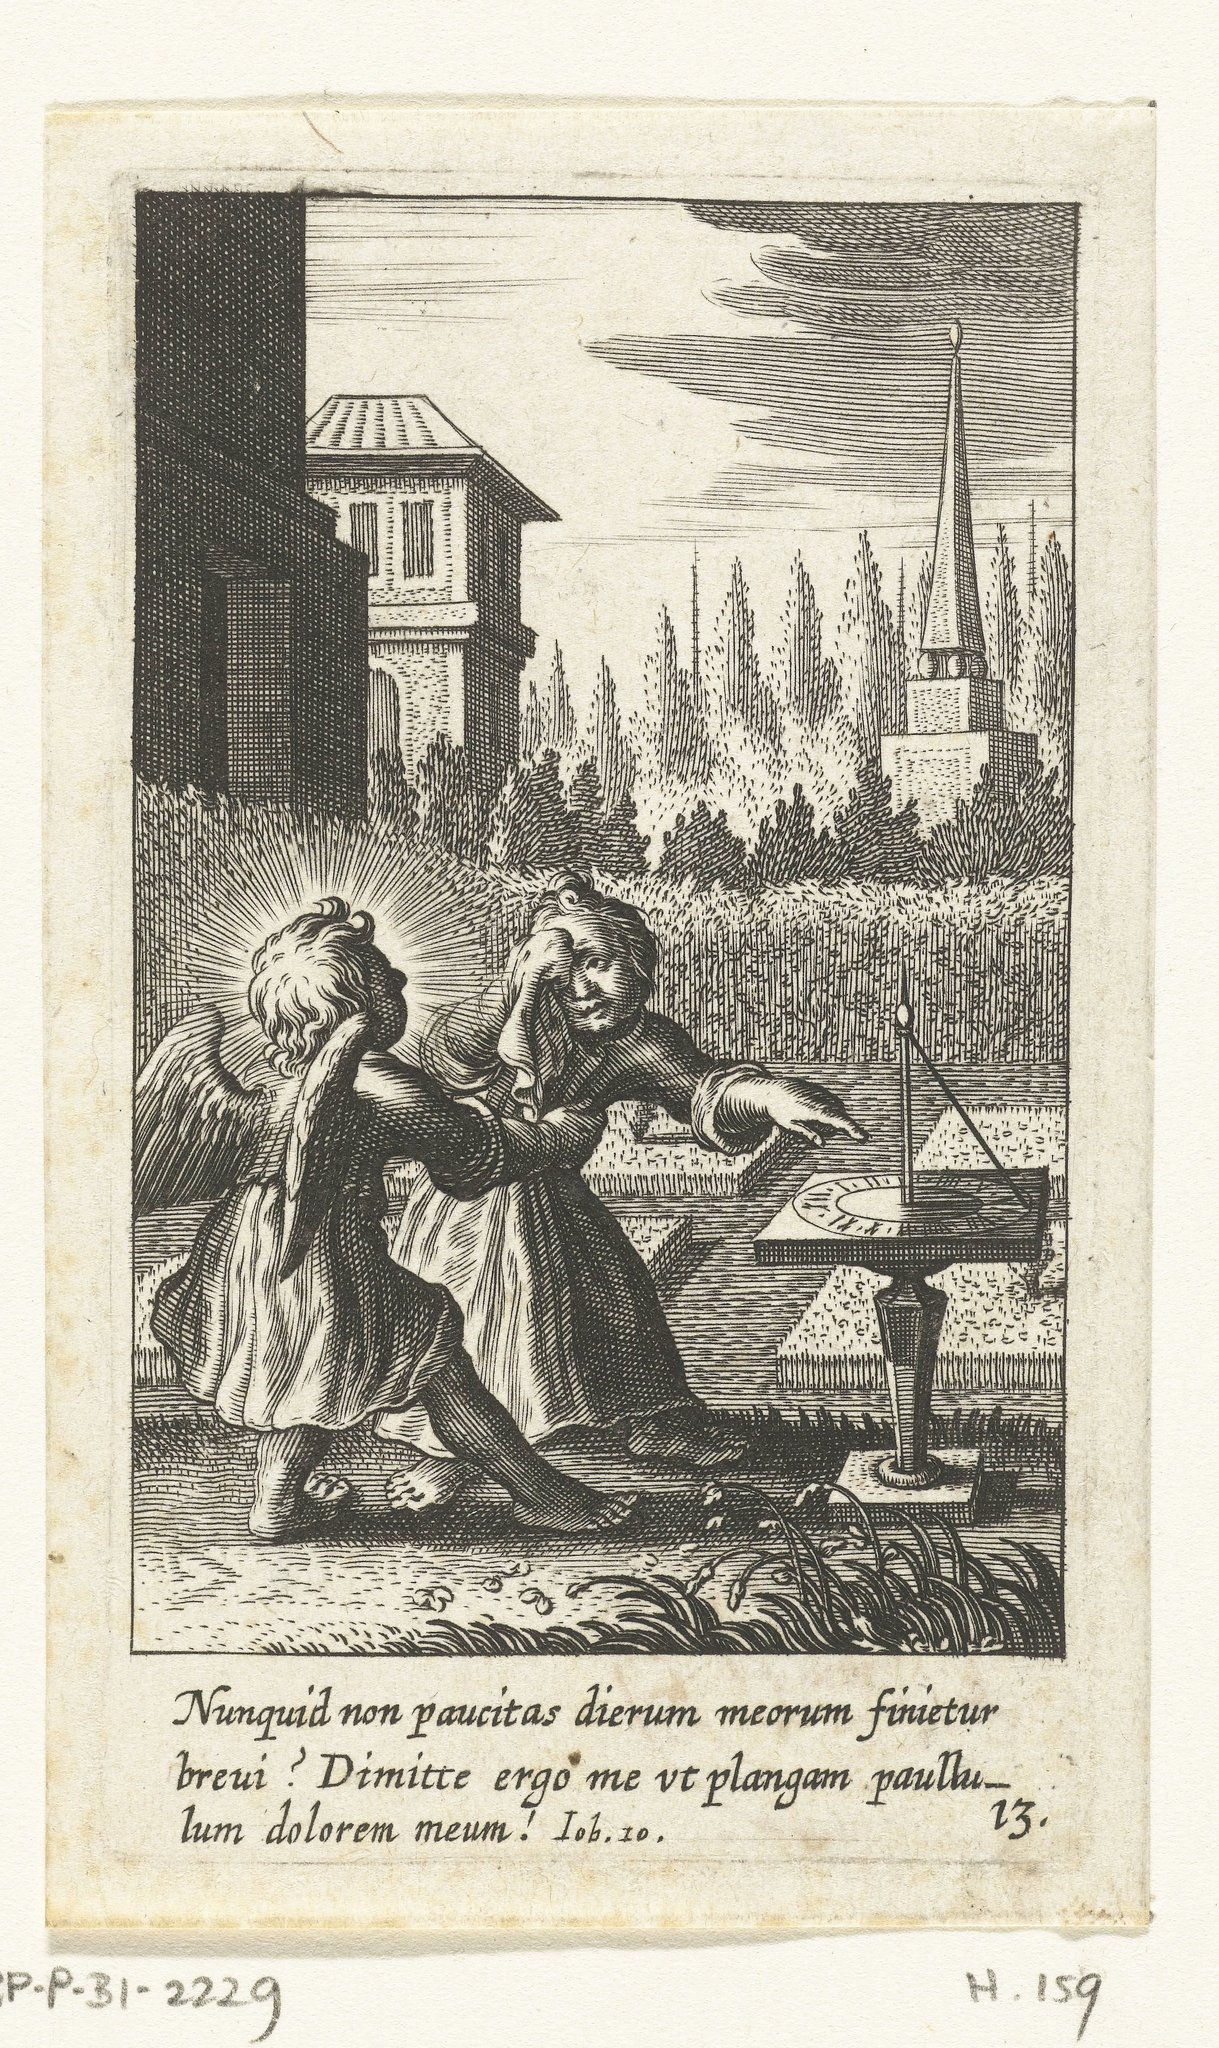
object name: print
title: Engel en kind bij zonnewijzer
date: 1590-1624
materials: paper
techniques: engraving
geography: antwerp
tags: sundial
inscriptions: collector's mark: Lugt 240, inscription: ‘Numquid non paucitas dierum, meorum finietur breui? dimitte ergo me, vt plangam paululùm dolorem meum’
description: Boekillustratie uit: Herman Hugo, Pia desideria emblematis, elegiis & affectibus S. S. Patrum illustrata, Antwerpen 1624, afb. 13